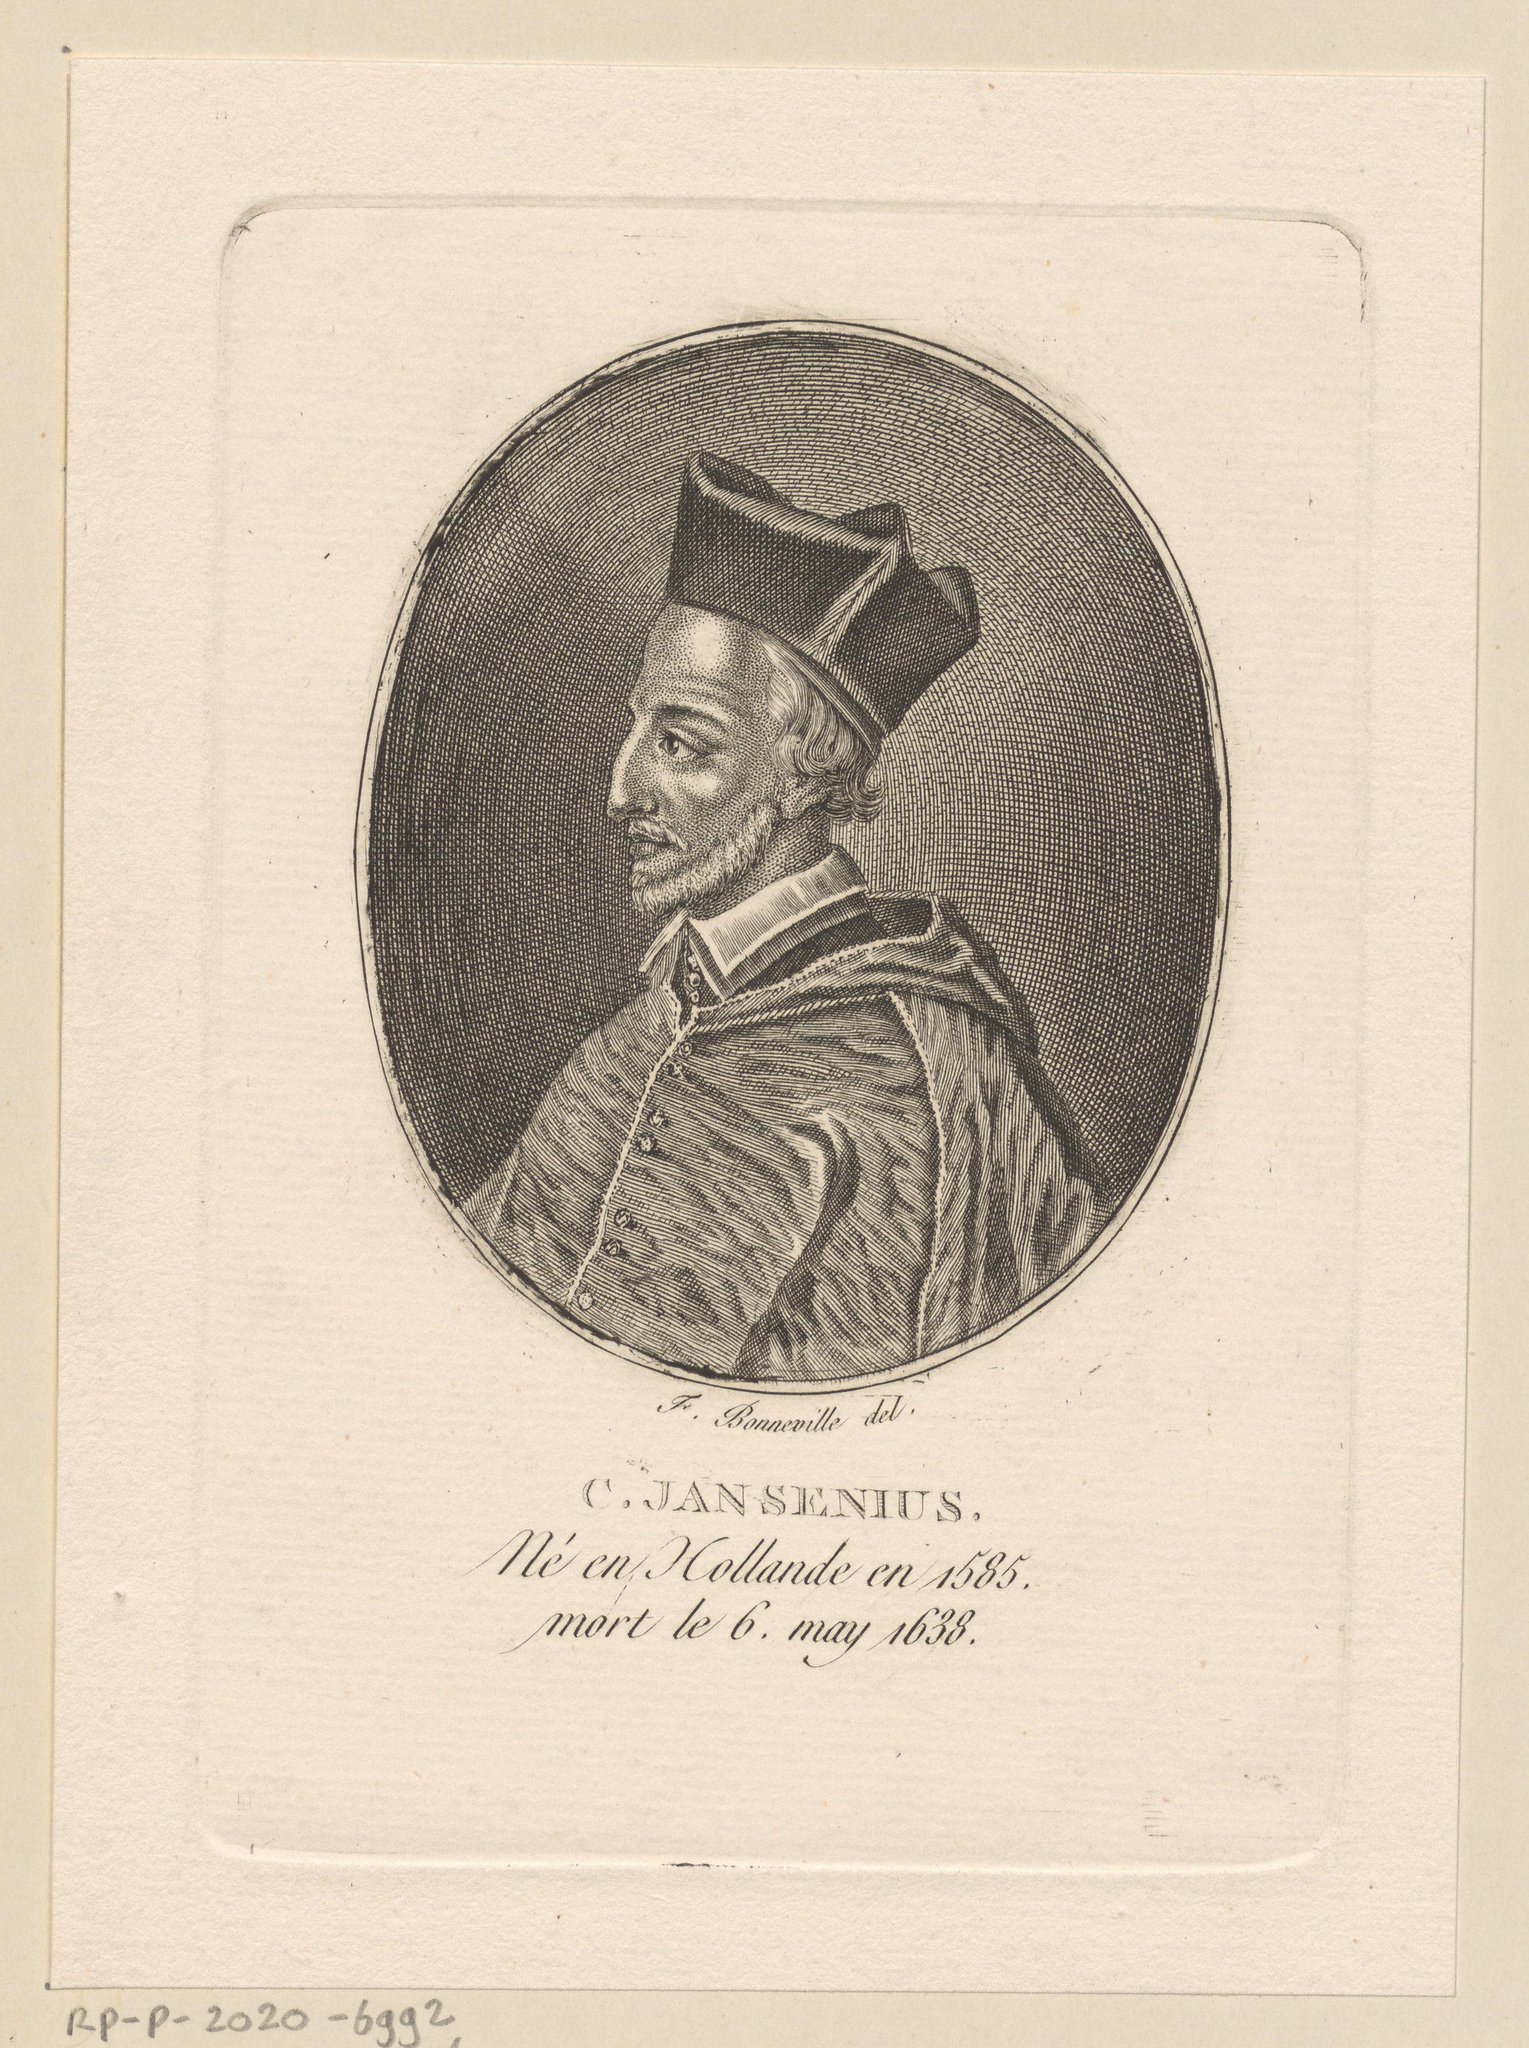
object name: print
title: Portret van Cornelius Jansenius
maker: françois bonneville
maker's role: draughtsman, painter, print maker, publisher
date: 1787-1814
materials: paper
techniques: engraving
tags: louvain, priest, archbishop, bishop, etc. (roman catholic), theologian, historical persons